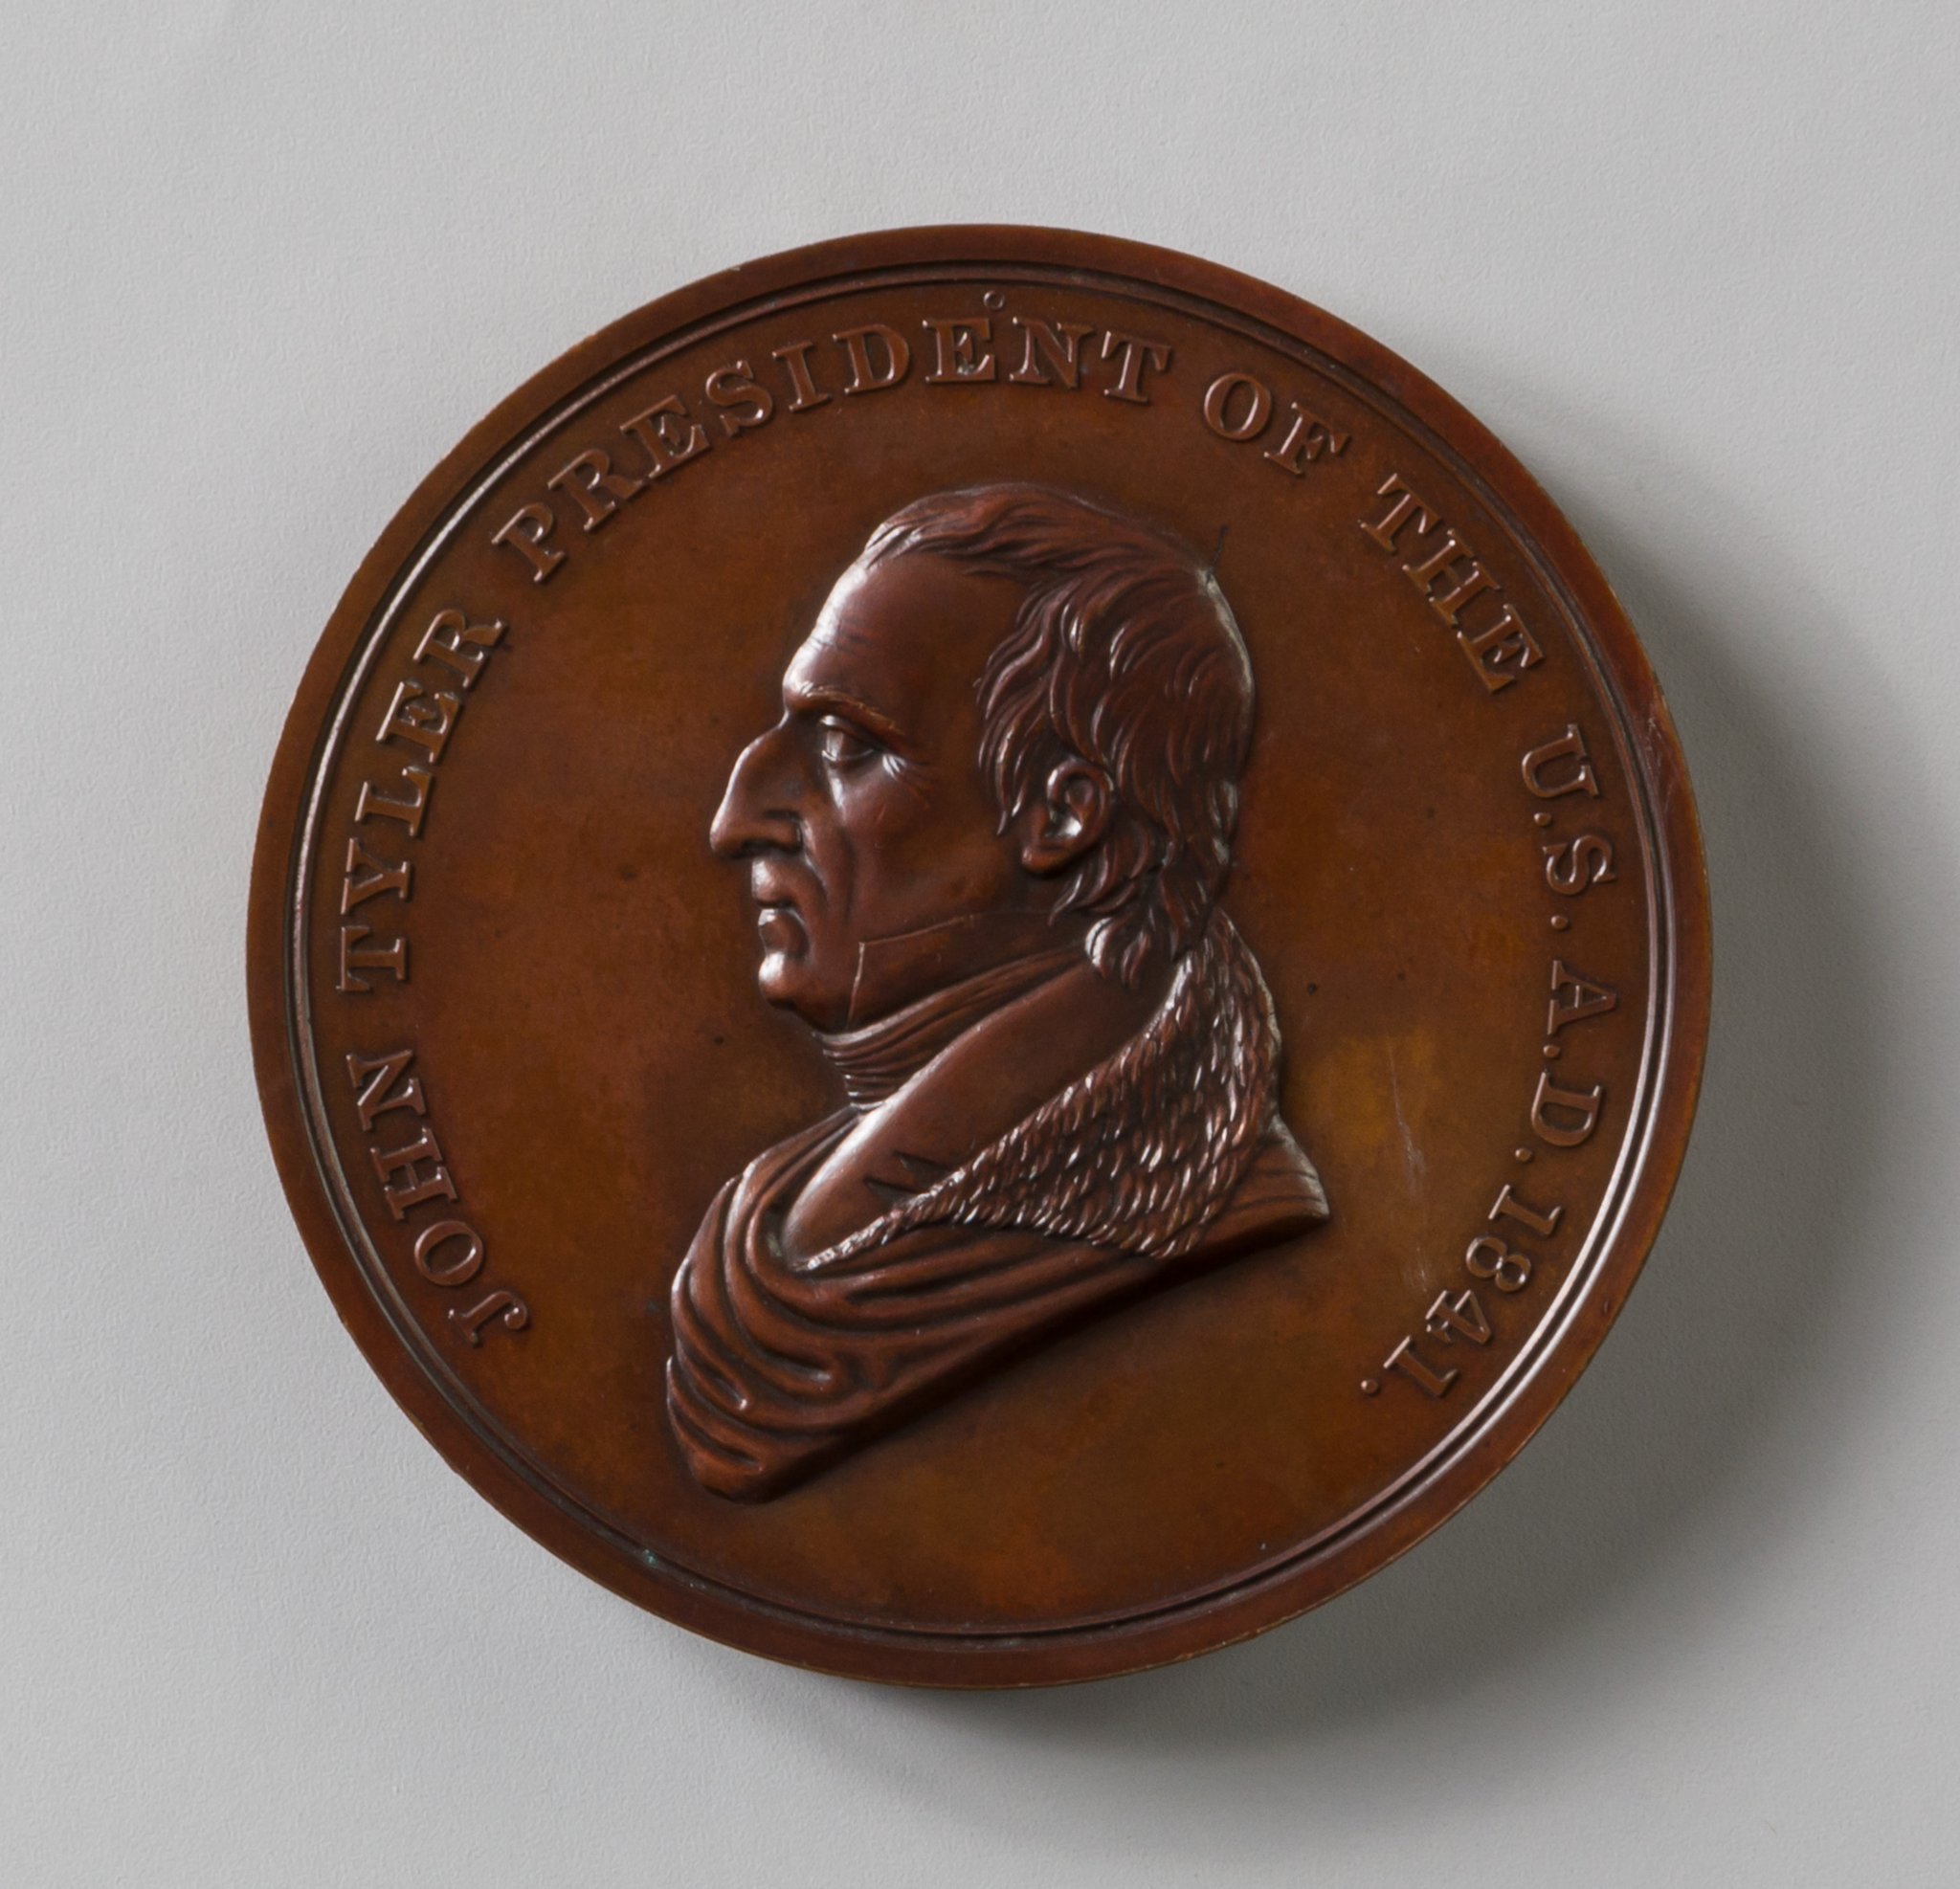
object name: medal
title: Medal of John Tyler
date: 1841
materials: bronze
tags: men,profiles